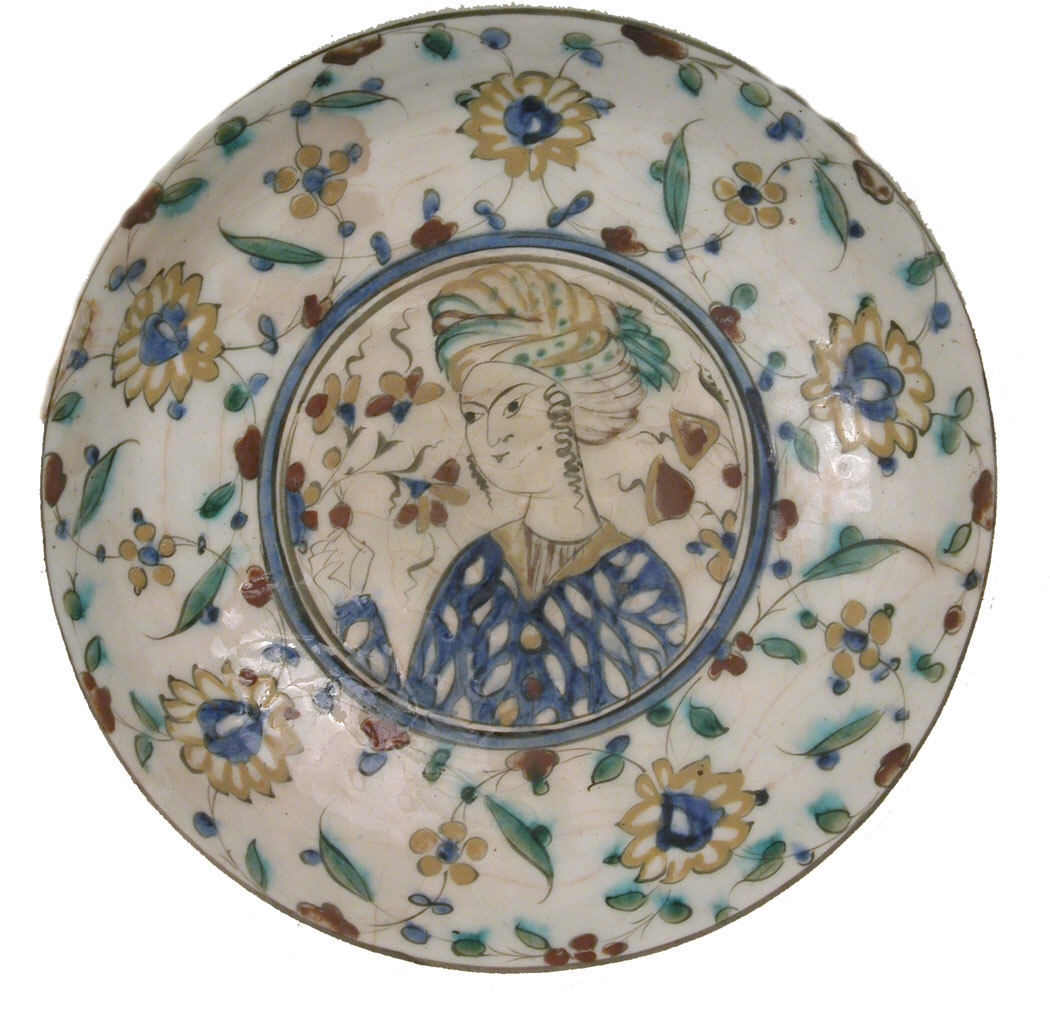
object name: plate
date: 1600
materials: stonepaste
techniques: painting, underglaze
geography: iran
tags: women